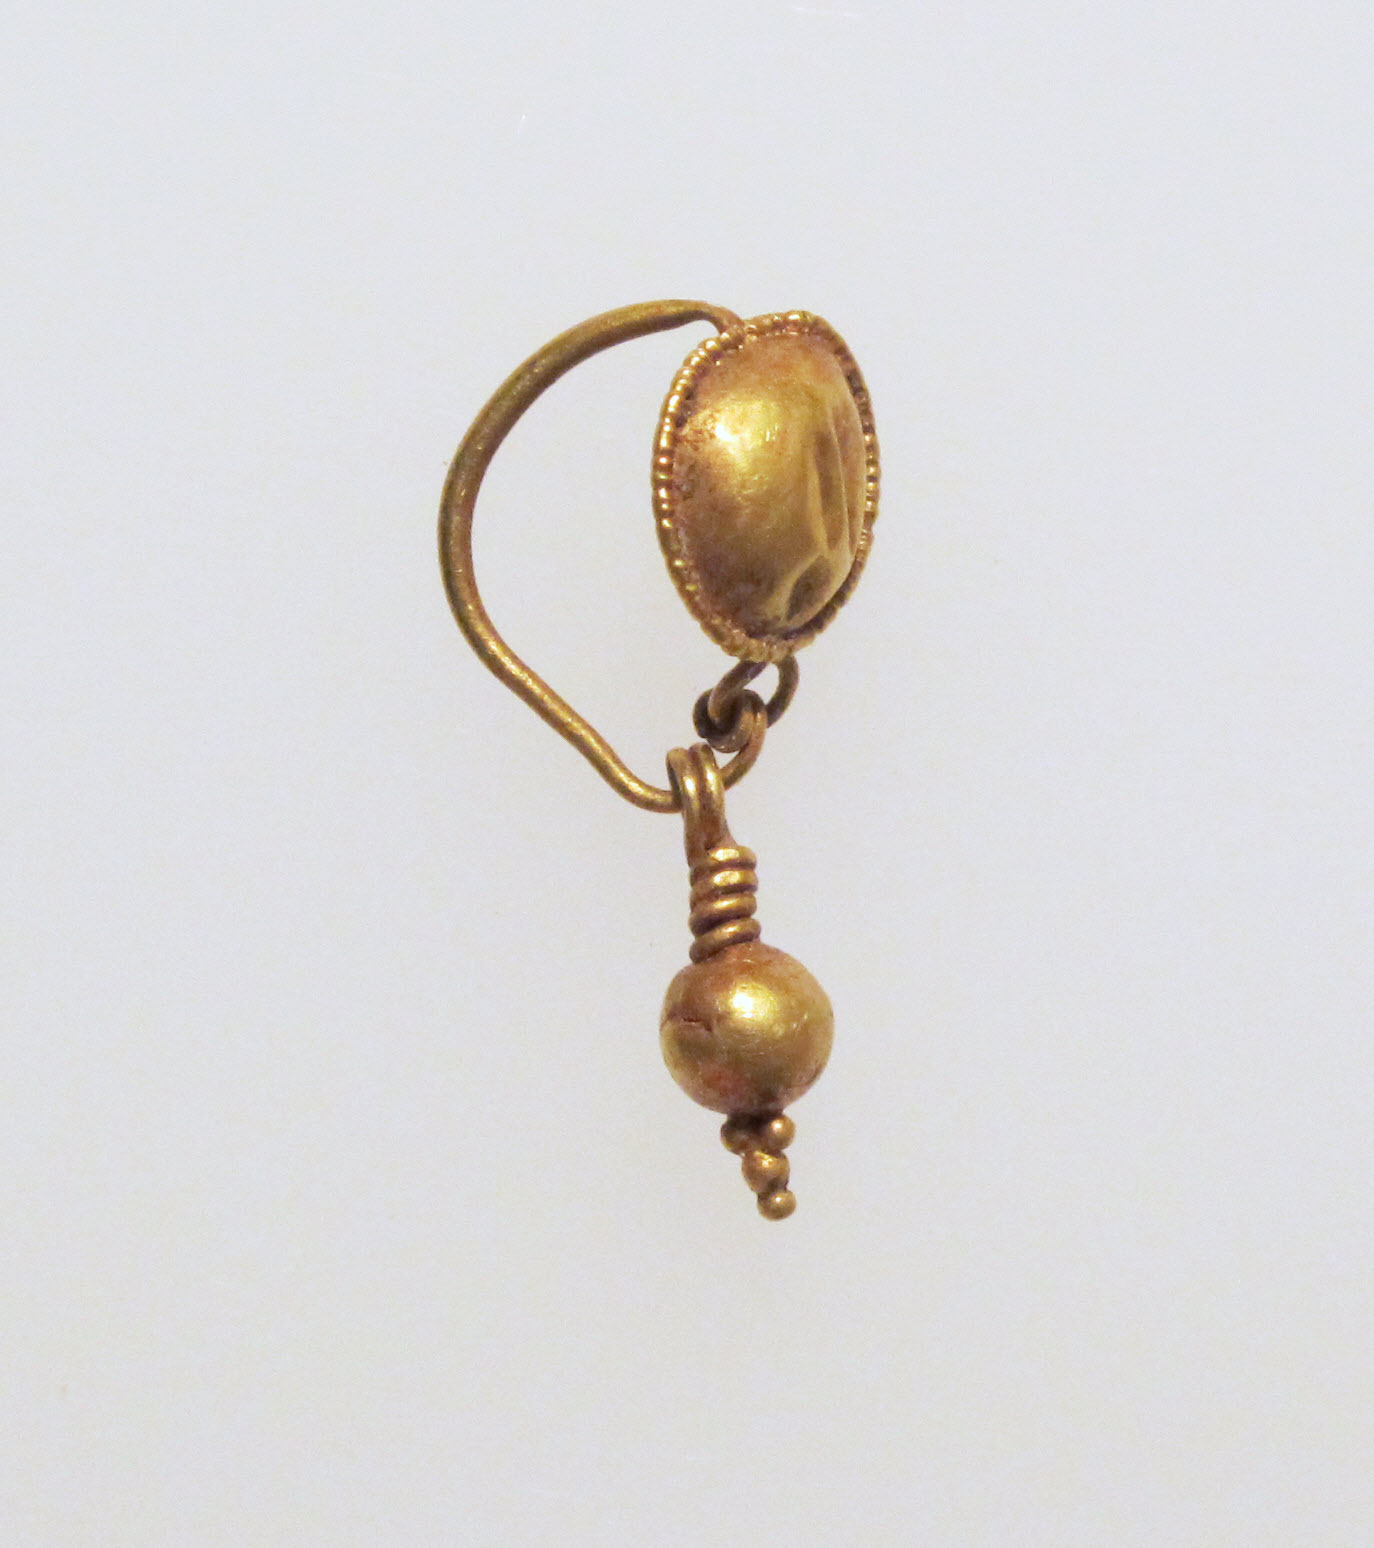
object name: earring with pendant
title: Gold earring with disc and pendant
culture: roman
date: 101-200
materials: gold